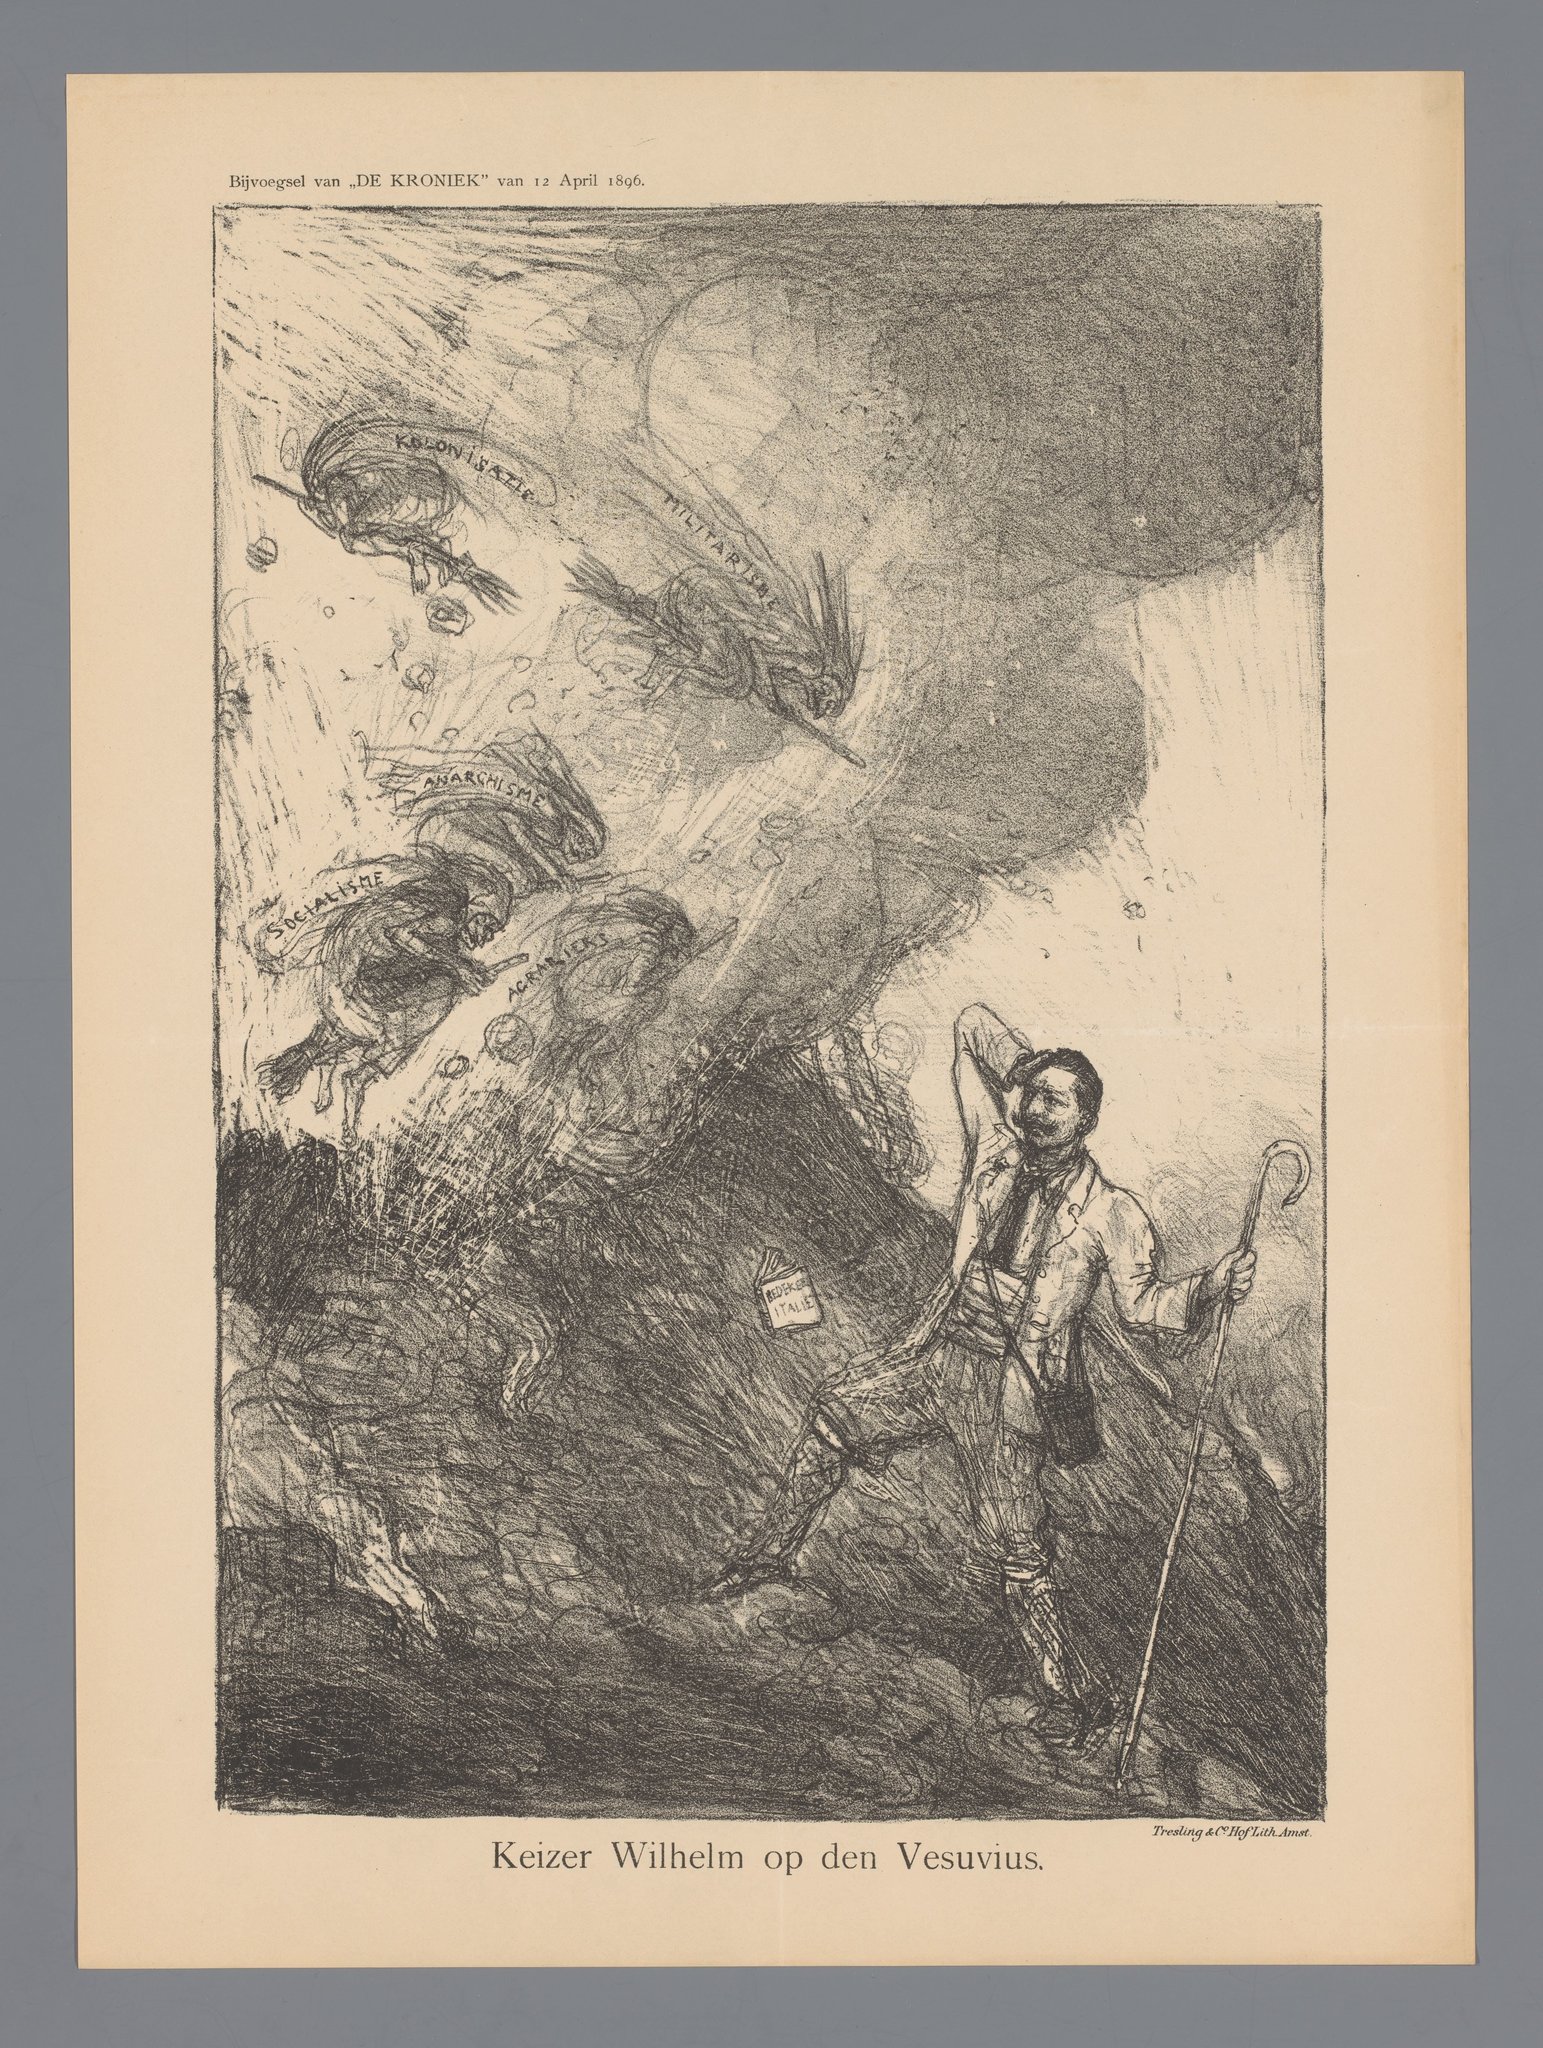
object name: cartoon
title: Keizer Wilhelm op den Vesuvius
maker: marius bauer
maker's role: draughtsman, print maker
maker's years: 1867-1932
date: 1896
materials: paper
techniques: lithograph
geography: amsterdam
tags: wilhelm ii (keizer van duitsland), historical persons, volcano, political caricatures and satires, mount vesuvius, germany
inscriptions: date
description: Spotprent op de uitbraak van de vulkaan Vesuvius tijdens het bezoek van de Duitse keizer Wilhelm II in april 1896. De keizer schrikt van de problemen in zijn eigen land (Anarchisme, Socialisme, Militarisme etc.) die verschijnen in de zwaveldampen.